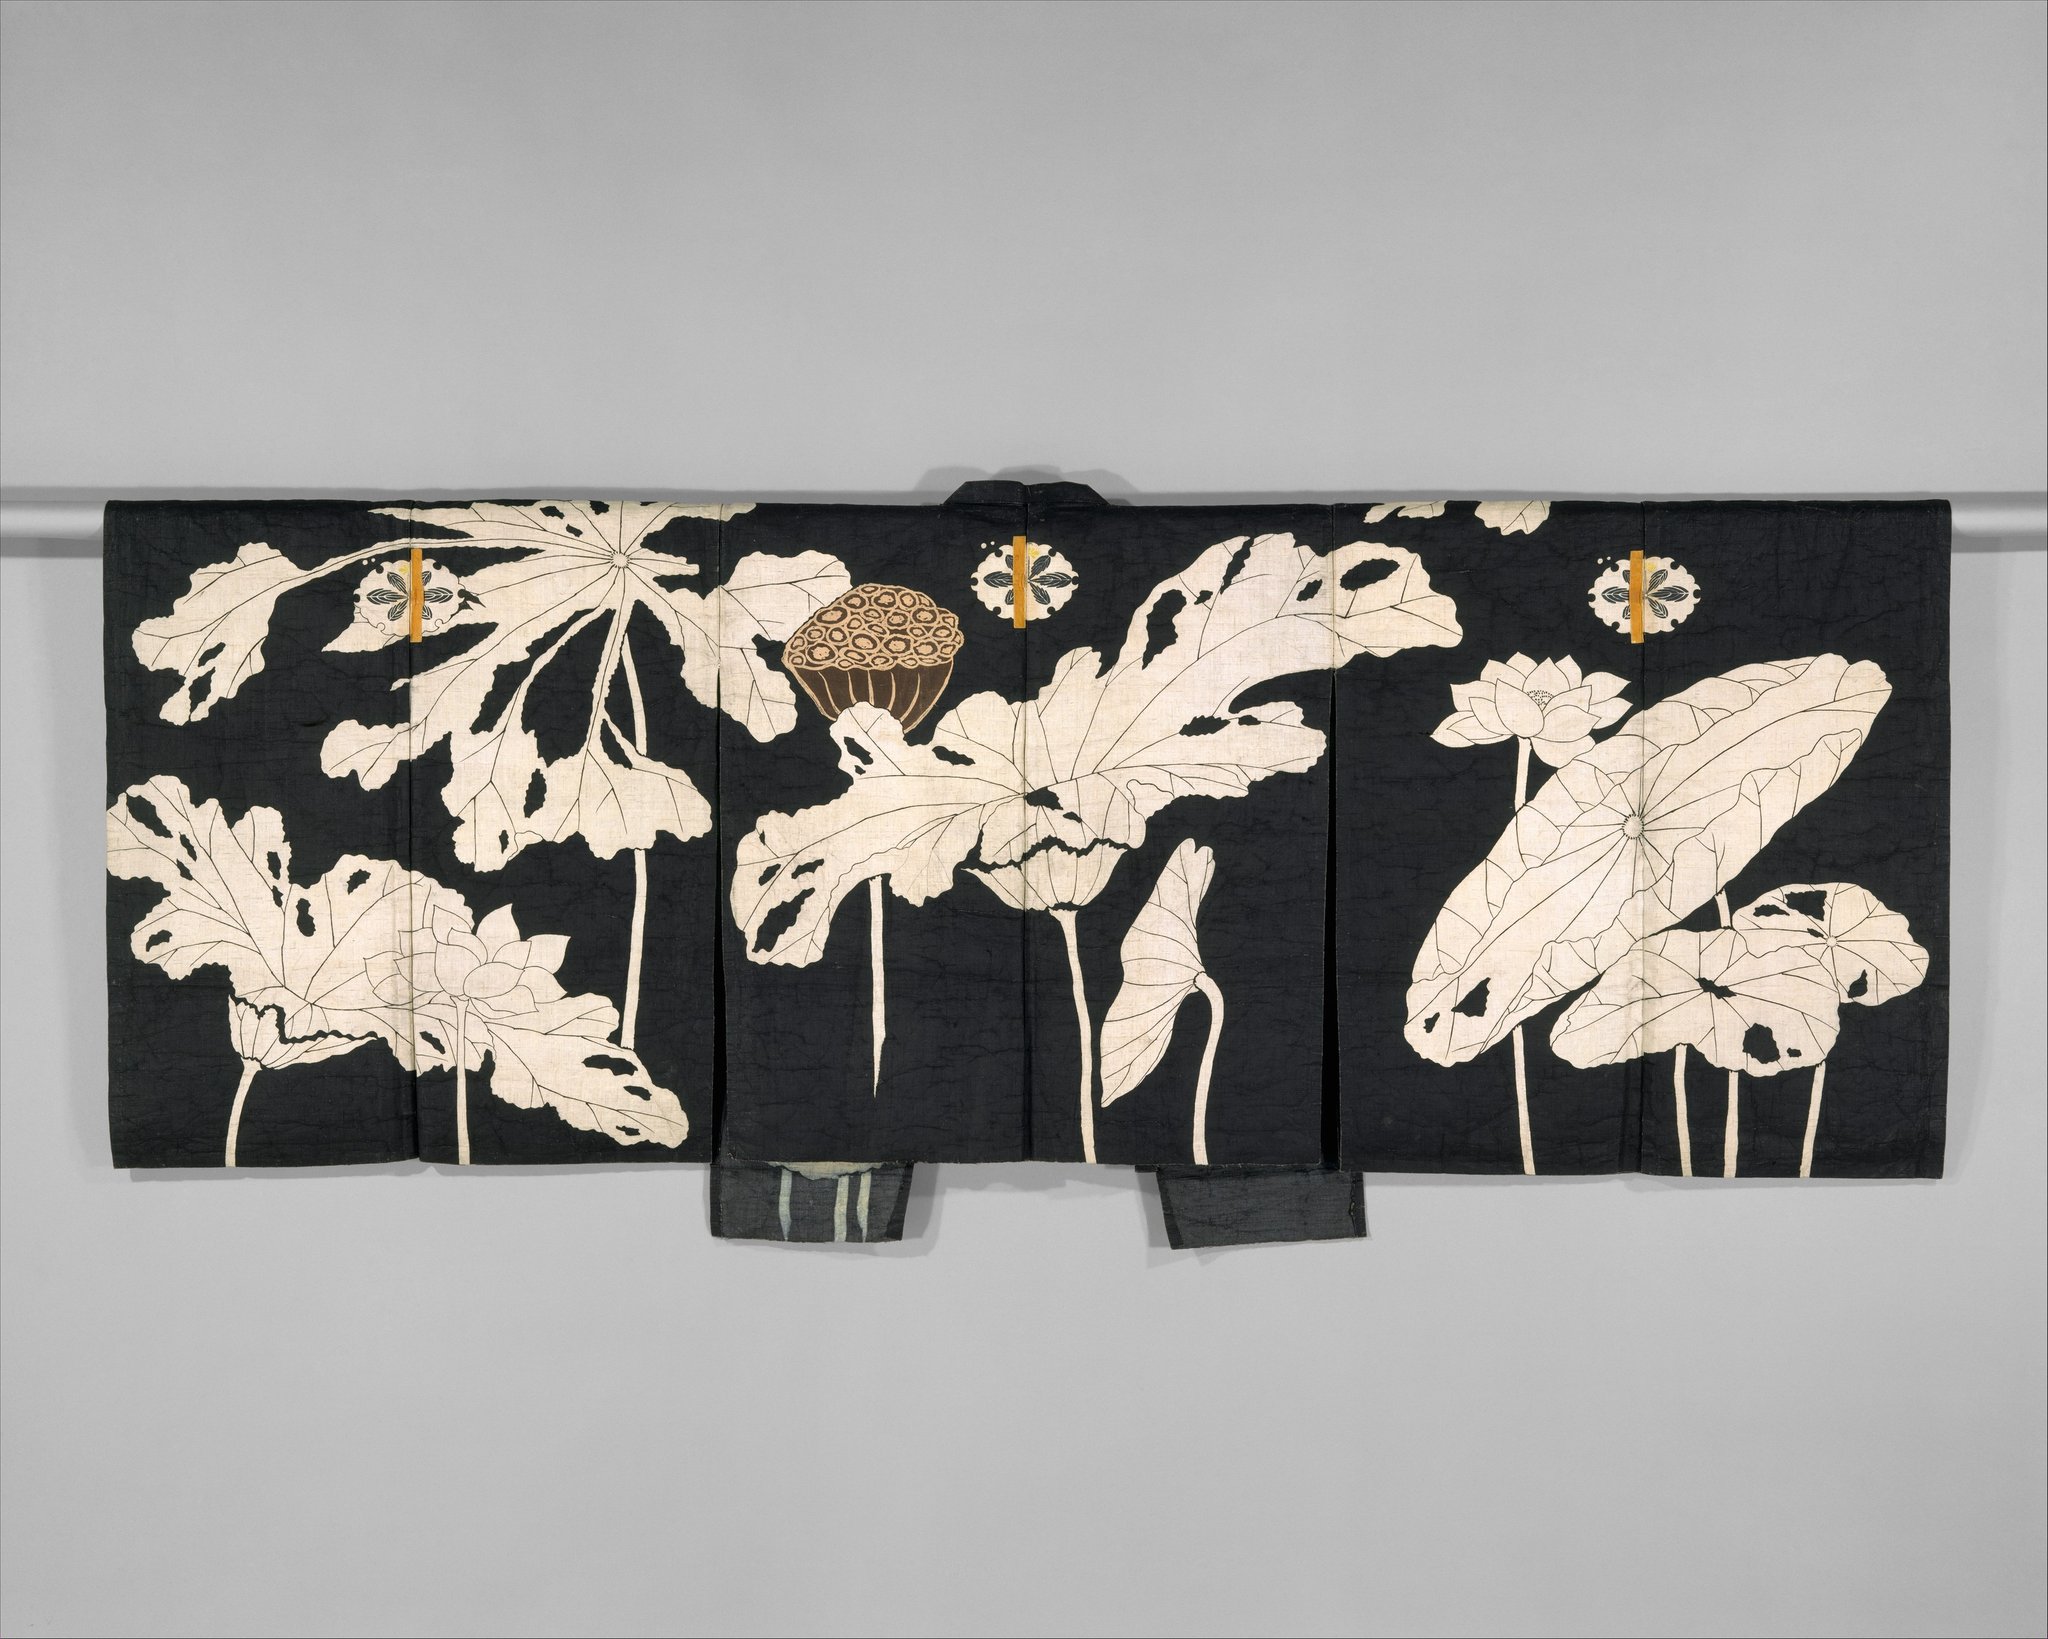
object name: kyogen costume jacket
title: Kyōgen Costume: Jacket (Suō) with Design of Lotuses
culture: japanese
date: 1801-1833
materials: fiber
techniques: dyeing, painting, weave, resist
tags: lotuses